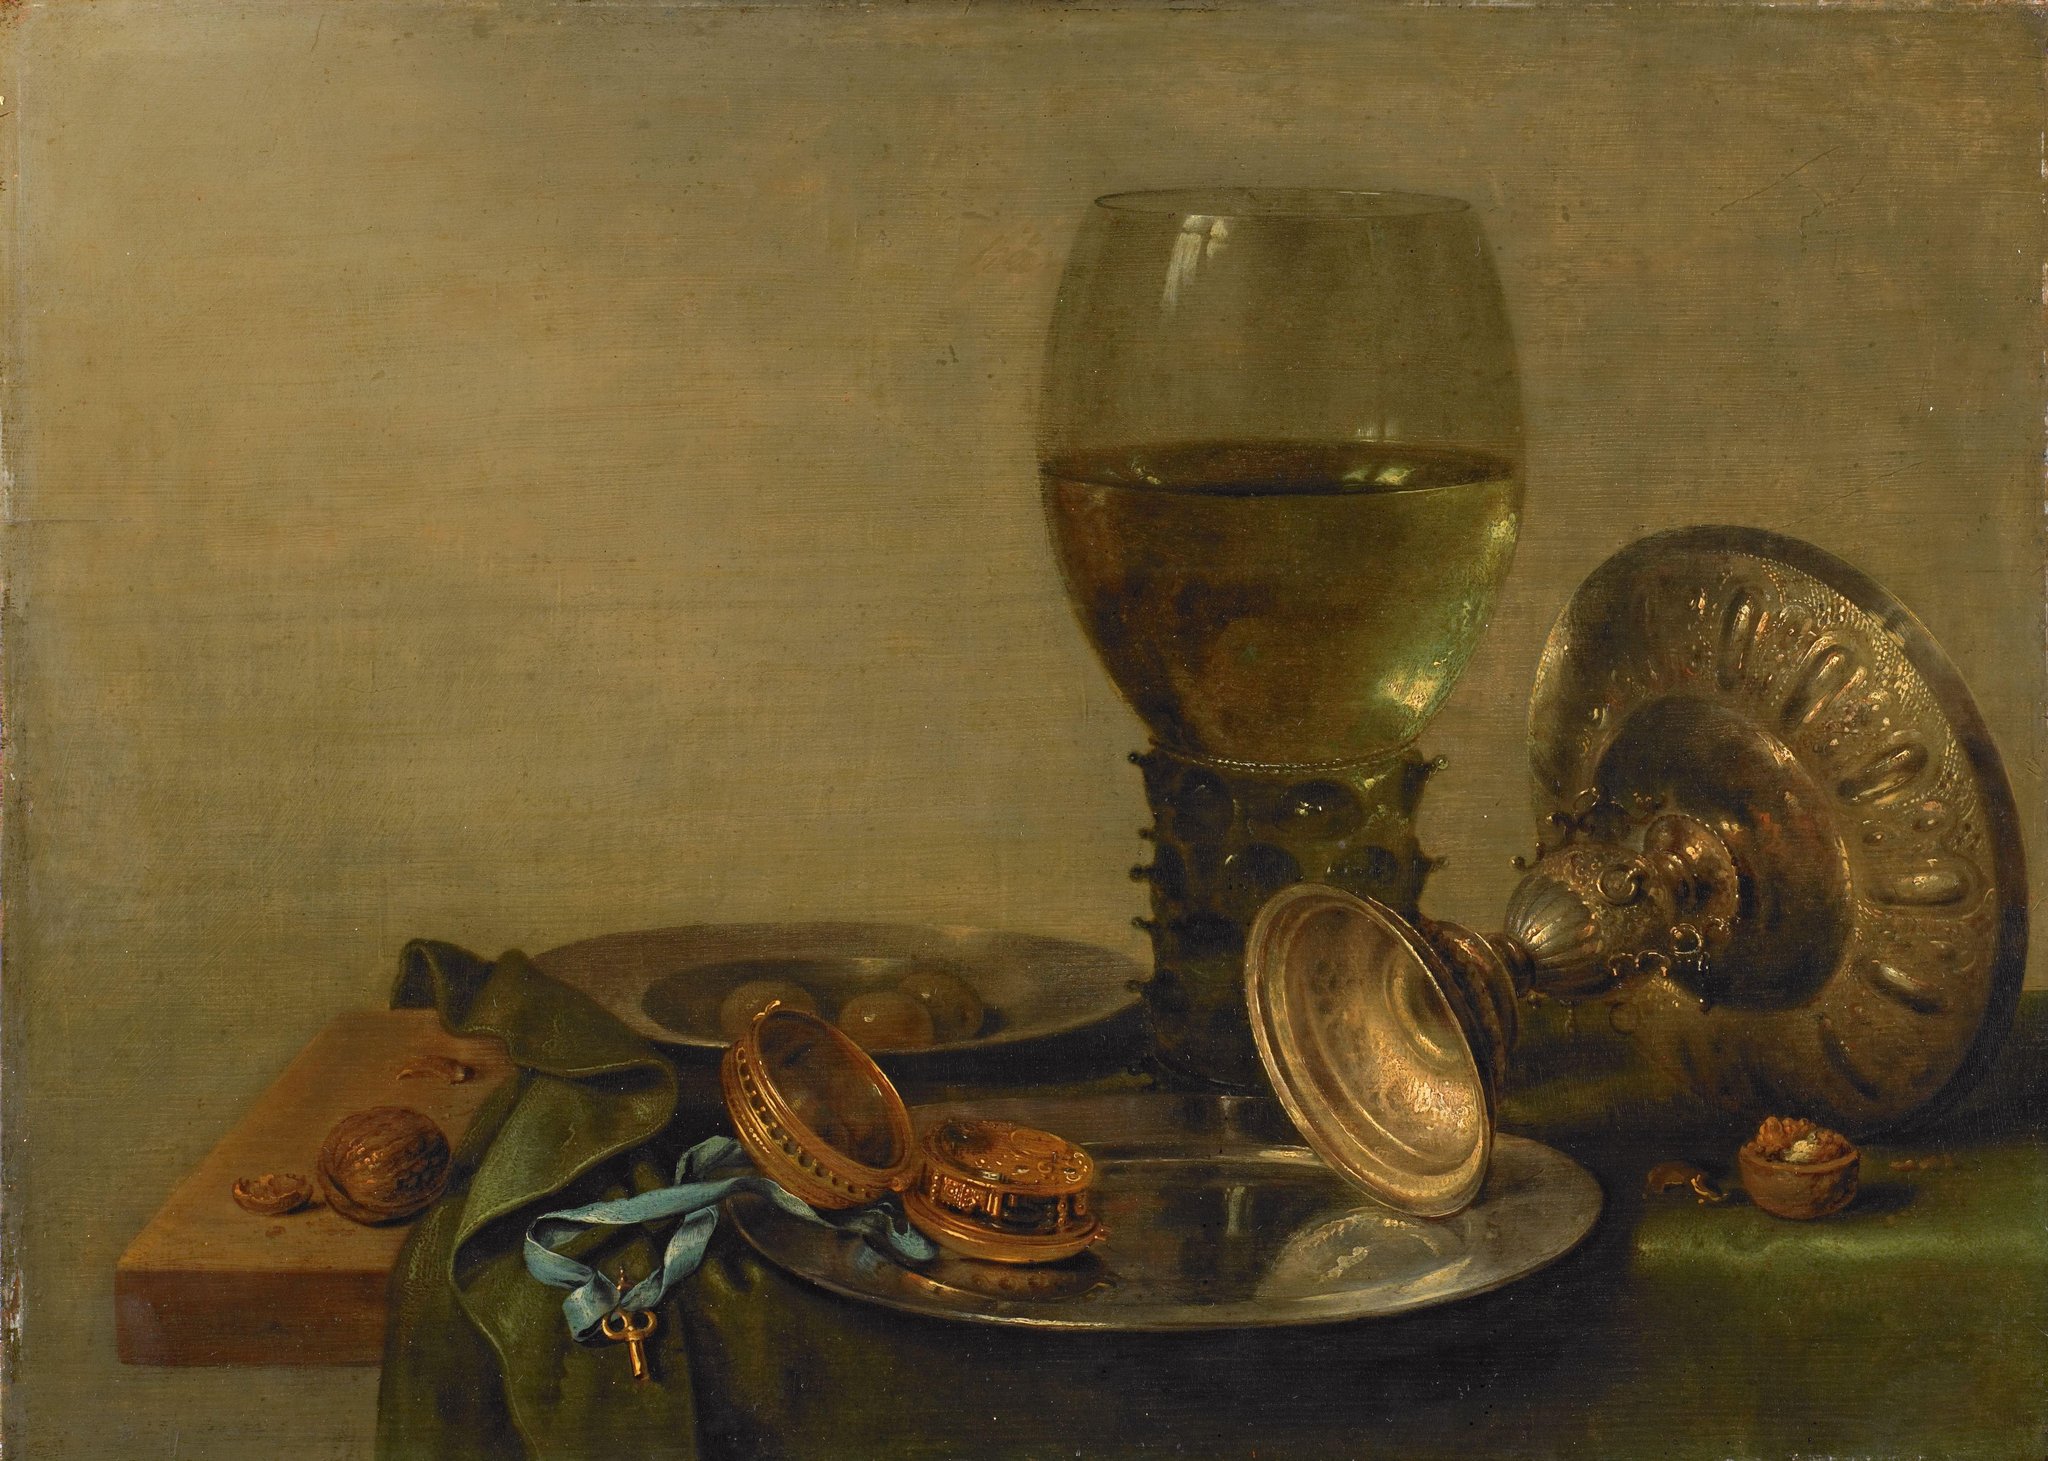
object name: painting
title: Still Life with a Silver Tazza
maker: willem claesz heda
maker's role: painter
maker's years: 1594-1680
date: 1630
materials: oil, paint, panel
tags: still life of related objects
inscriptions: signature and date, traces on the edge of the table on the left: ‘Heda.1630’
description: Stilleven met roemer, tazza, uurwerkje, twee tinnen borden, olijven en walnoten op een gedeeltelijk bedekte tafel.